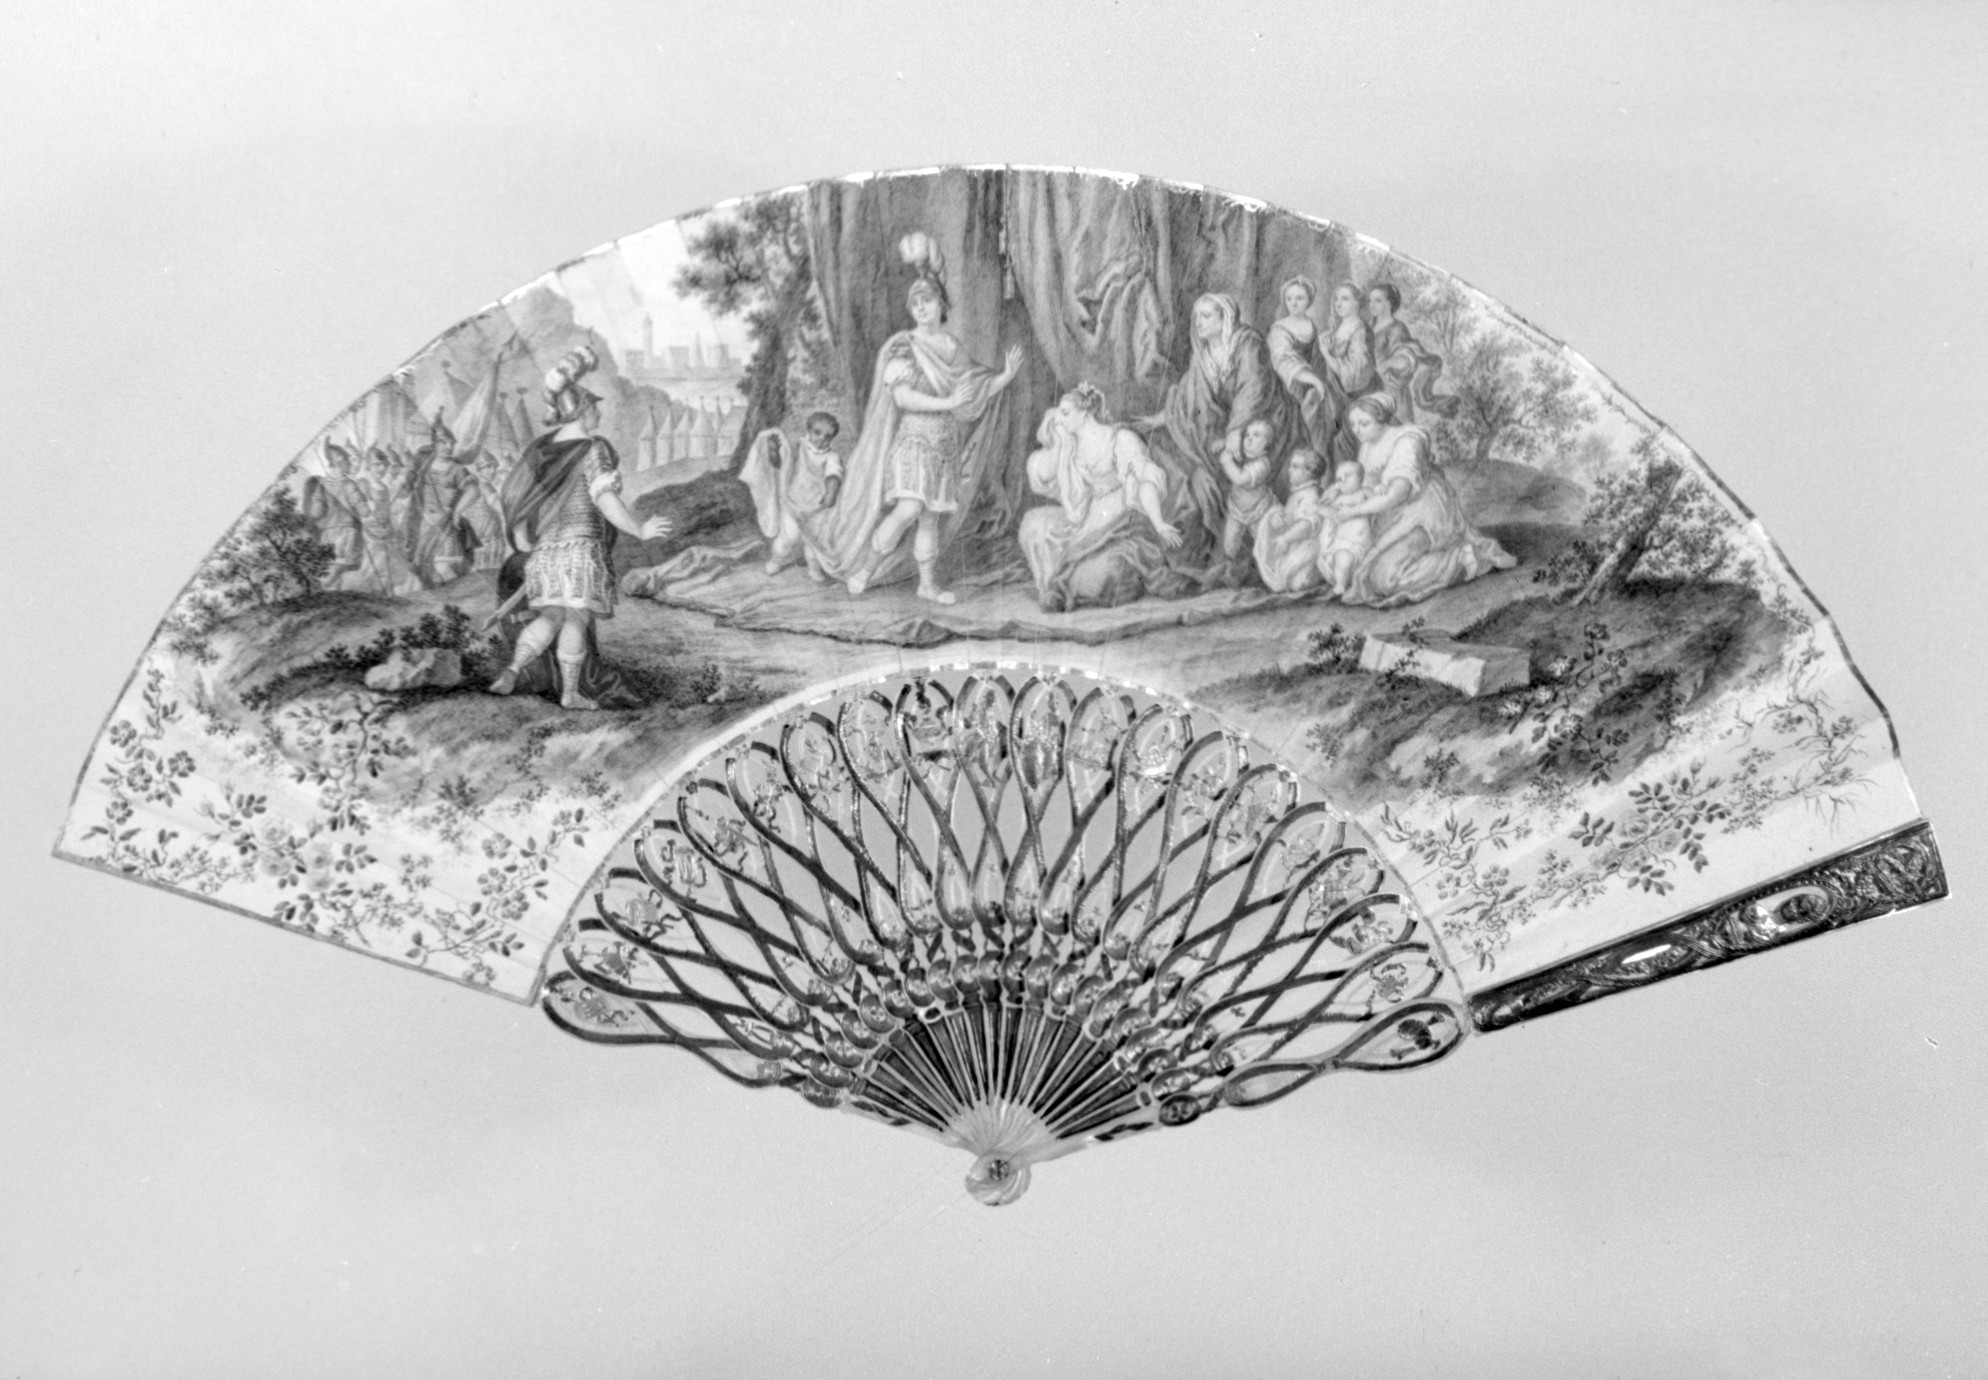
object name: fan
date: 1701-1800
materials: mother of pearl, parchment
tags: children,men,women